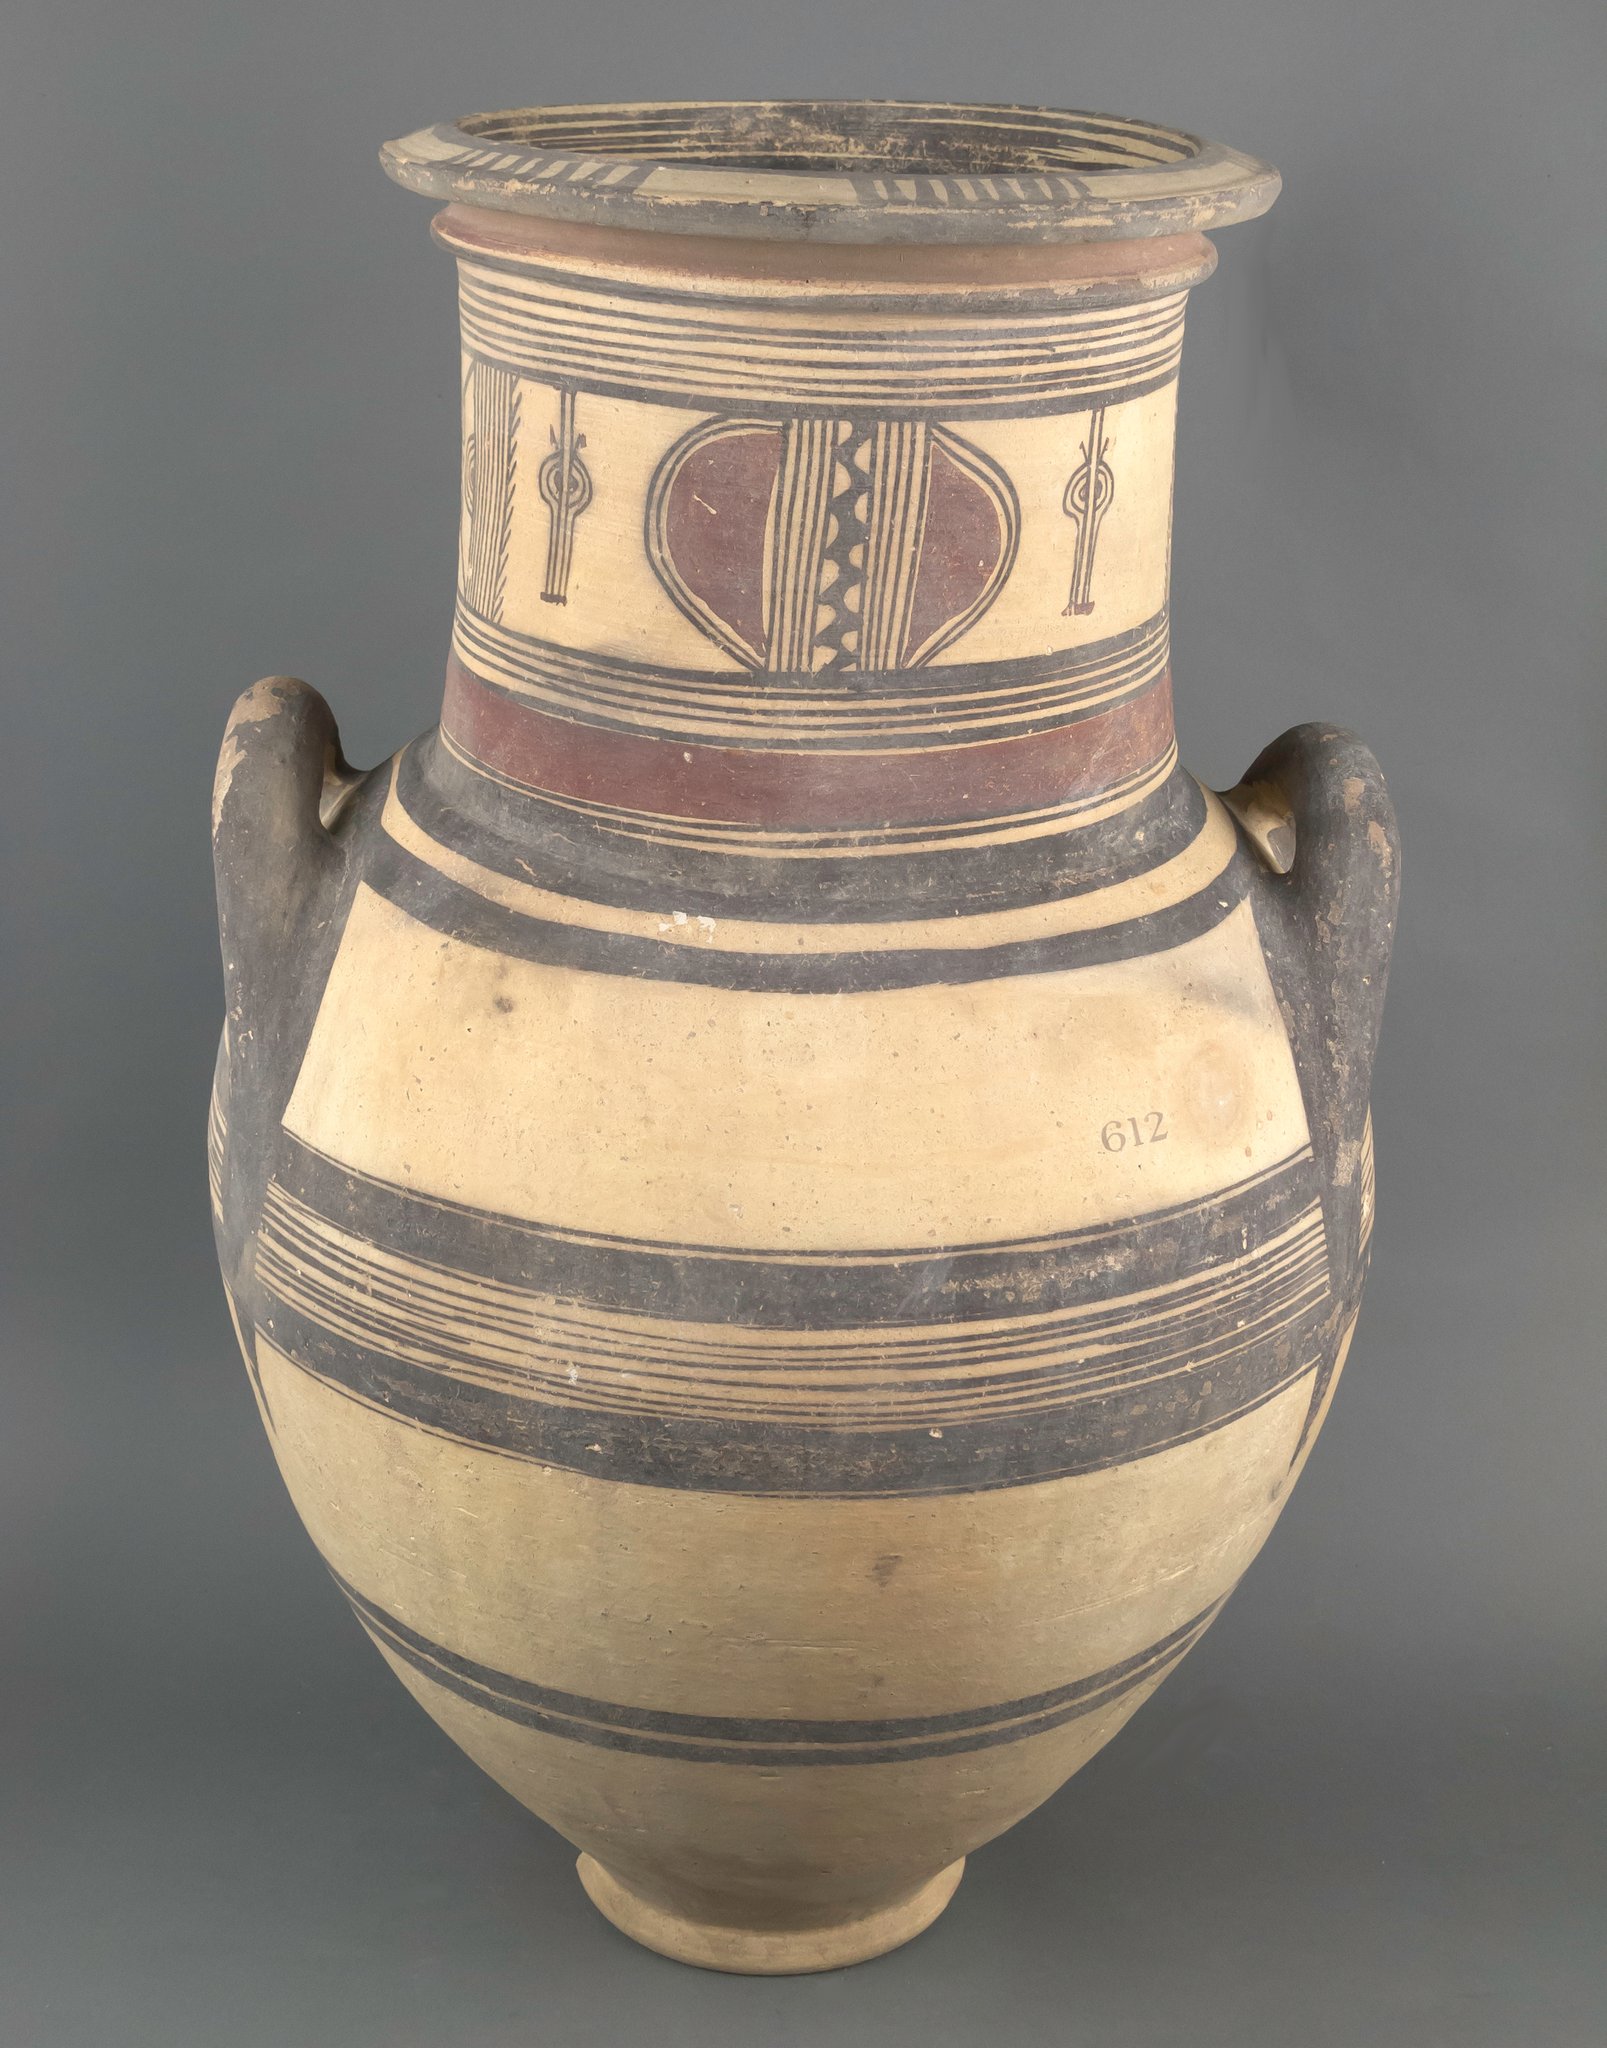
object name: amphora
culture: cypriot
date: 750-600 BCE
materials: terracotta